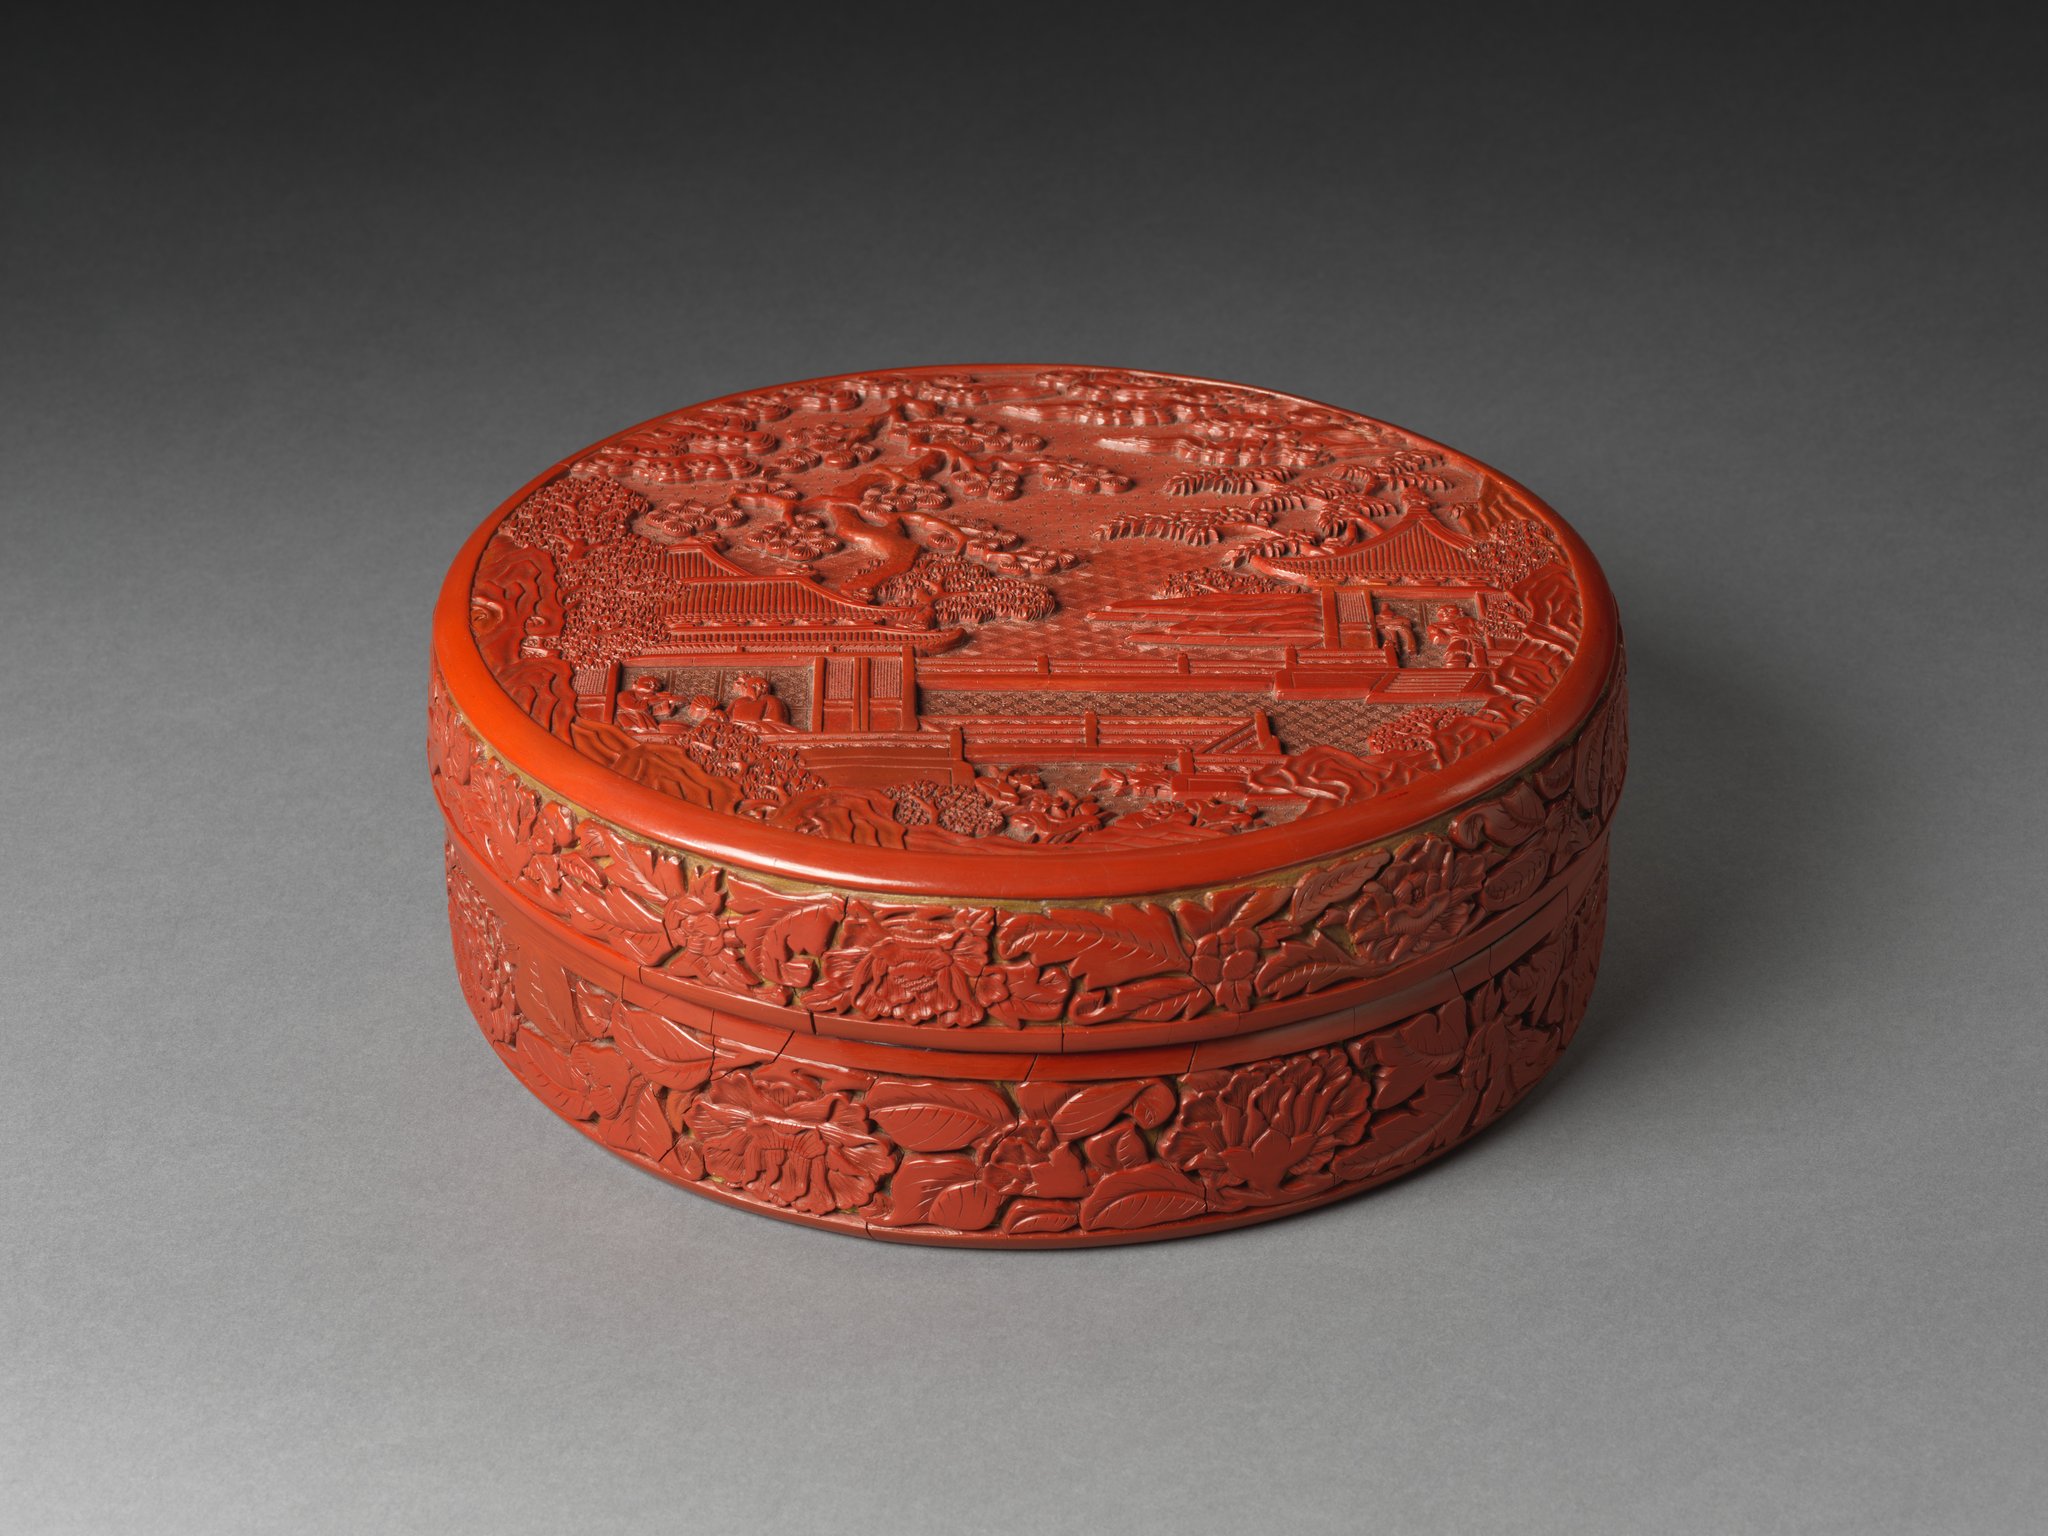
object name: box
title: Covered box with figures in a garden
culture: chinese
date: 1426-1435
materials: lacquer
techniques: carving